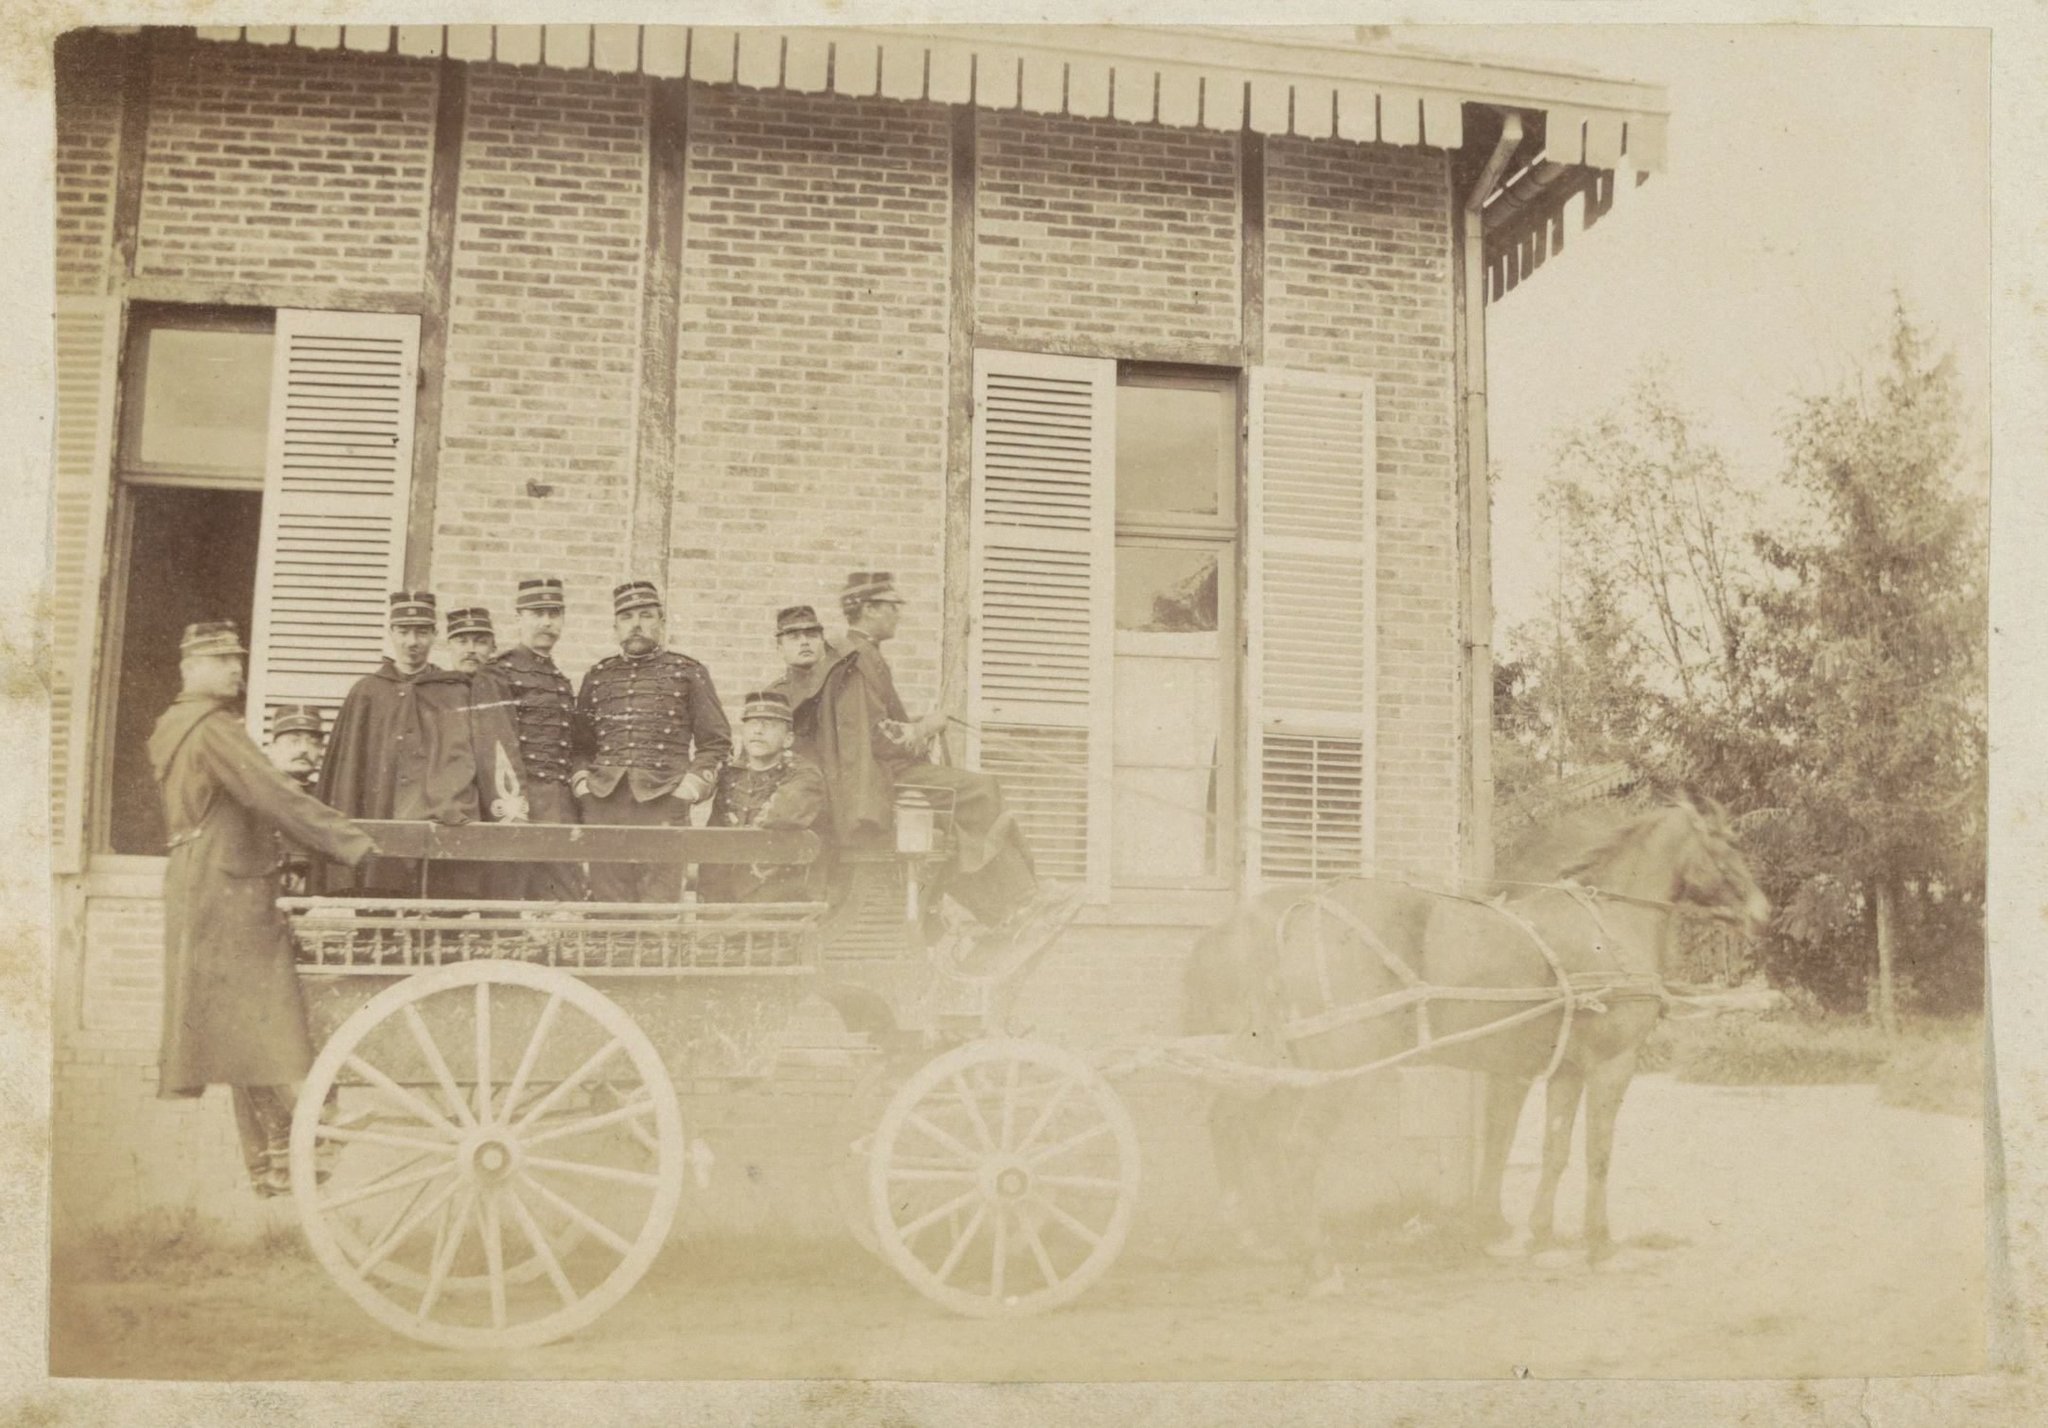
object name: photograph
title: Groep Franse militairen in een paardenkoets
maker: Anonymous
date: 1805-1884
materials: photographic support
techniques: albumen print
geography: france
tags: four-wheeled, animal-drawn vehicle, e.g.: cab, carriage, coach, land forces, france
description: Onderdeel van Album van een Franse amateurfotograaf met opnames van familie, militairen, industrie, landschappen en bezienswaardigheden in Frankrijk.